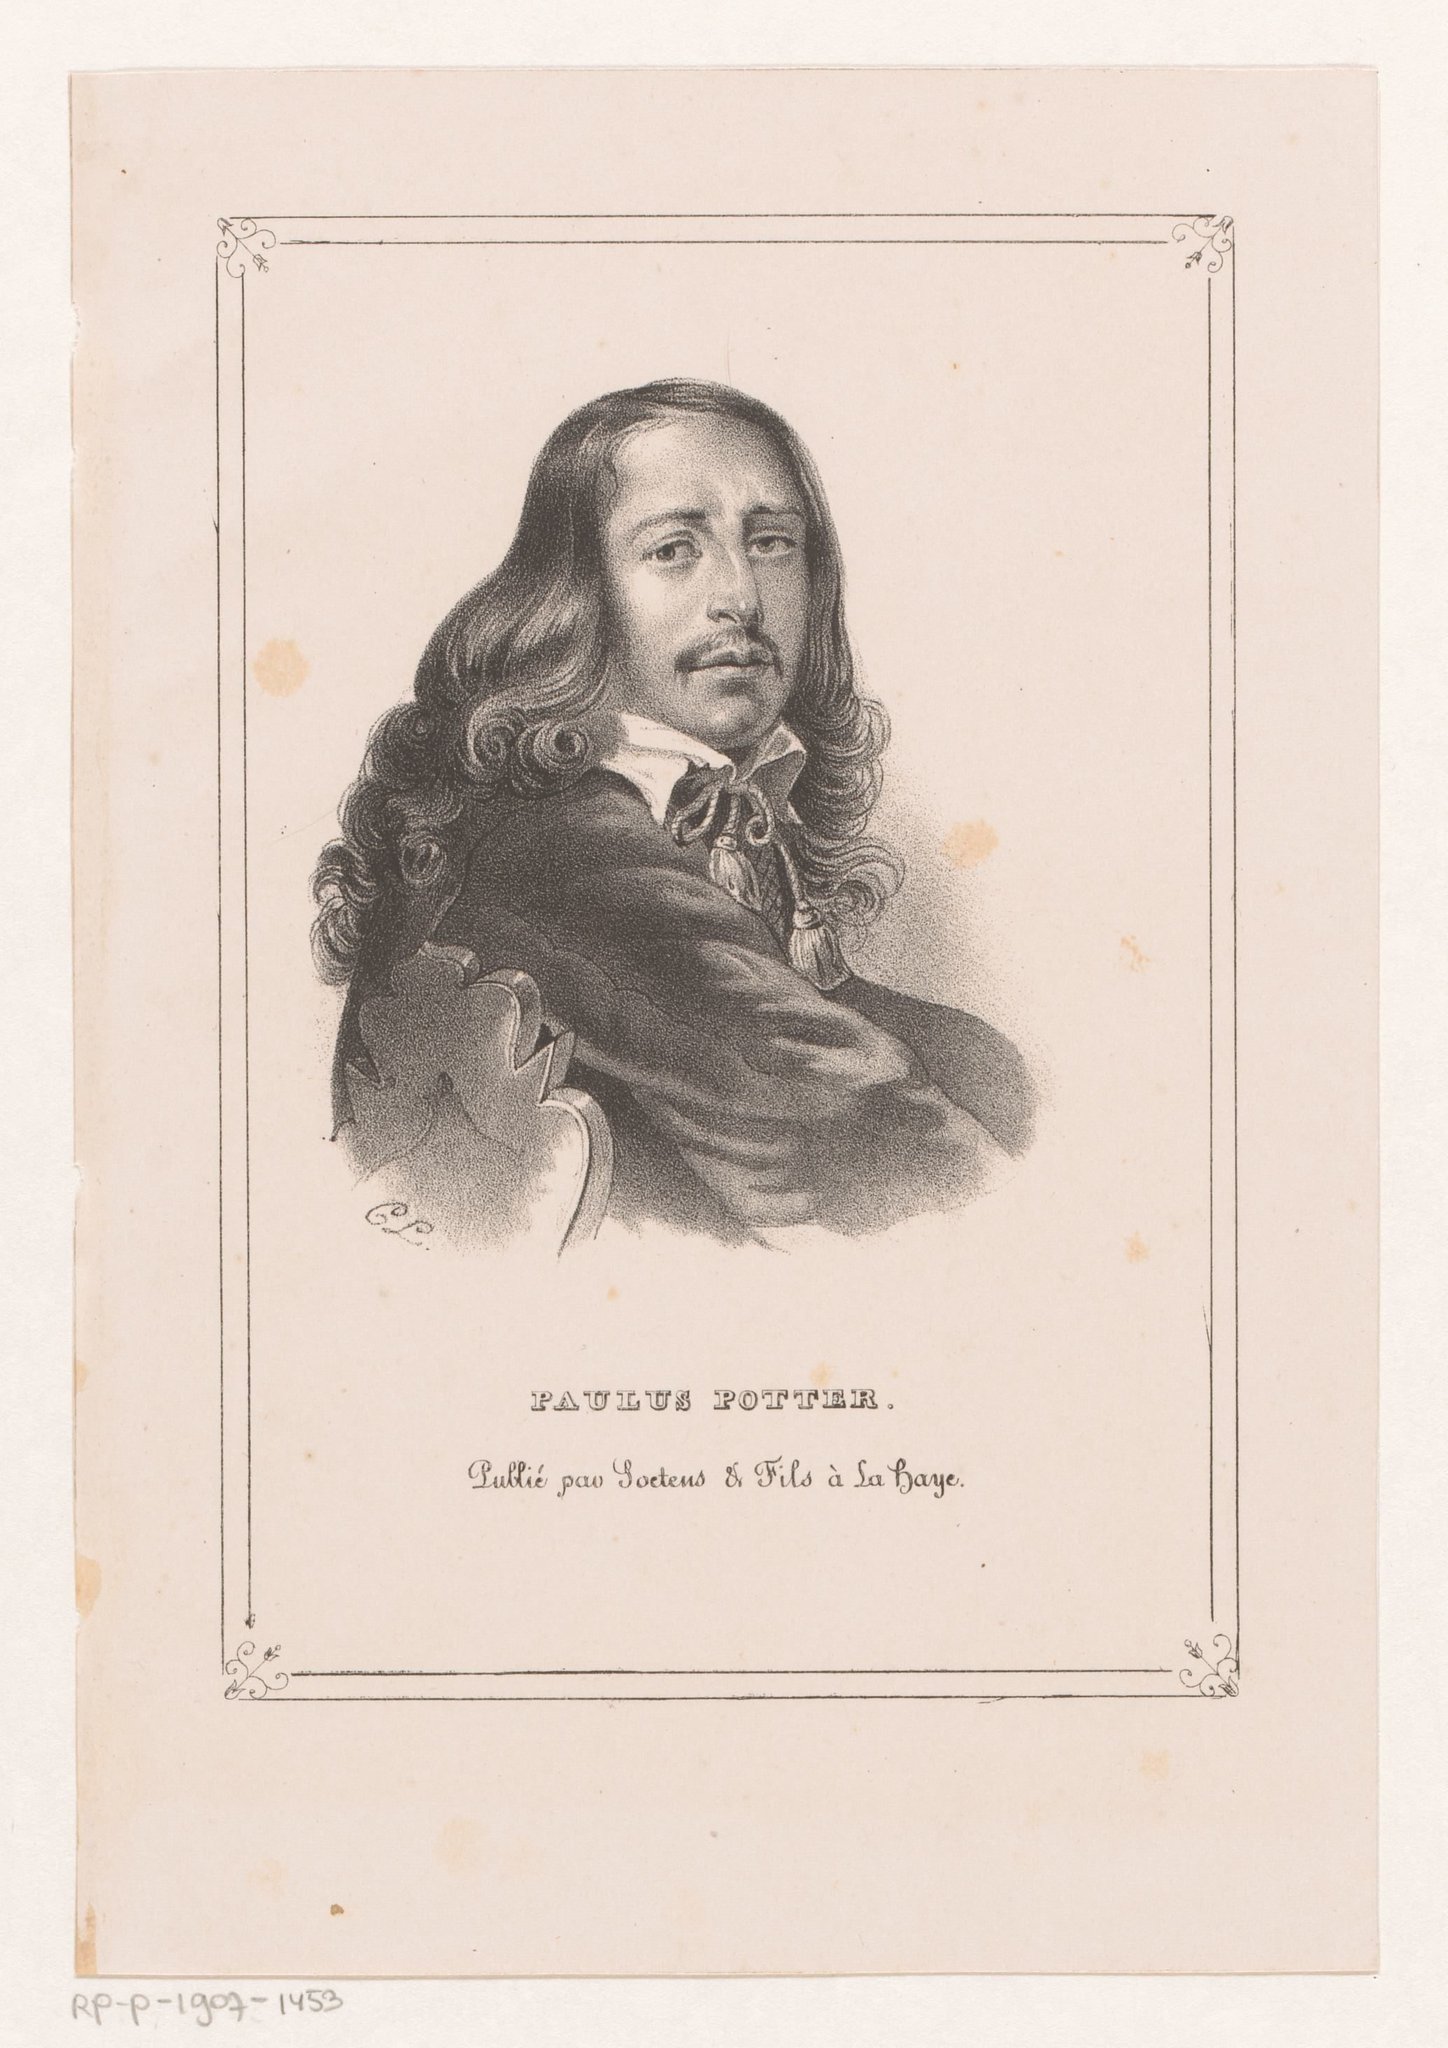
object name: print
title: Serie portretten door Soetens & Fils omstreeks 1838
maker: carel christiaan antony last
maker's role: print maker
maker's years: 1808-1876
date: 1839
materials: paper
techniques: lithograph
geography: the hague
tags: enkhuizen, amsterdam, painter, print maker, draughtsman, paulus potter, historical persons (+ (full) bust portrait), arms crossed over the breast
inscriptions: collector's mark: Lugt 2228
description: De geportretteerde heeft zijn armen voor zijn borst gekruist.